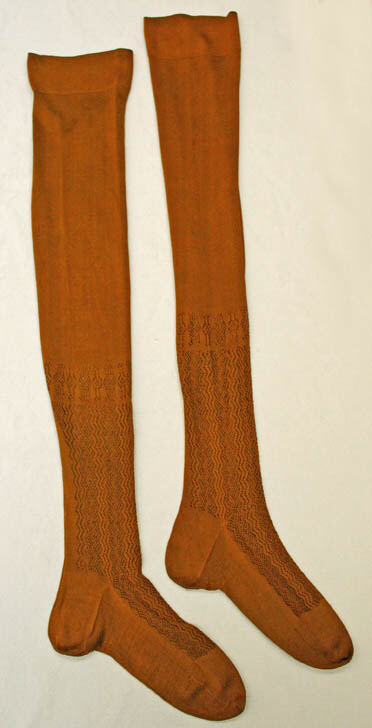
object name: stocking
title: Stockings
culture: french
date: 1875-1899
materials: silk